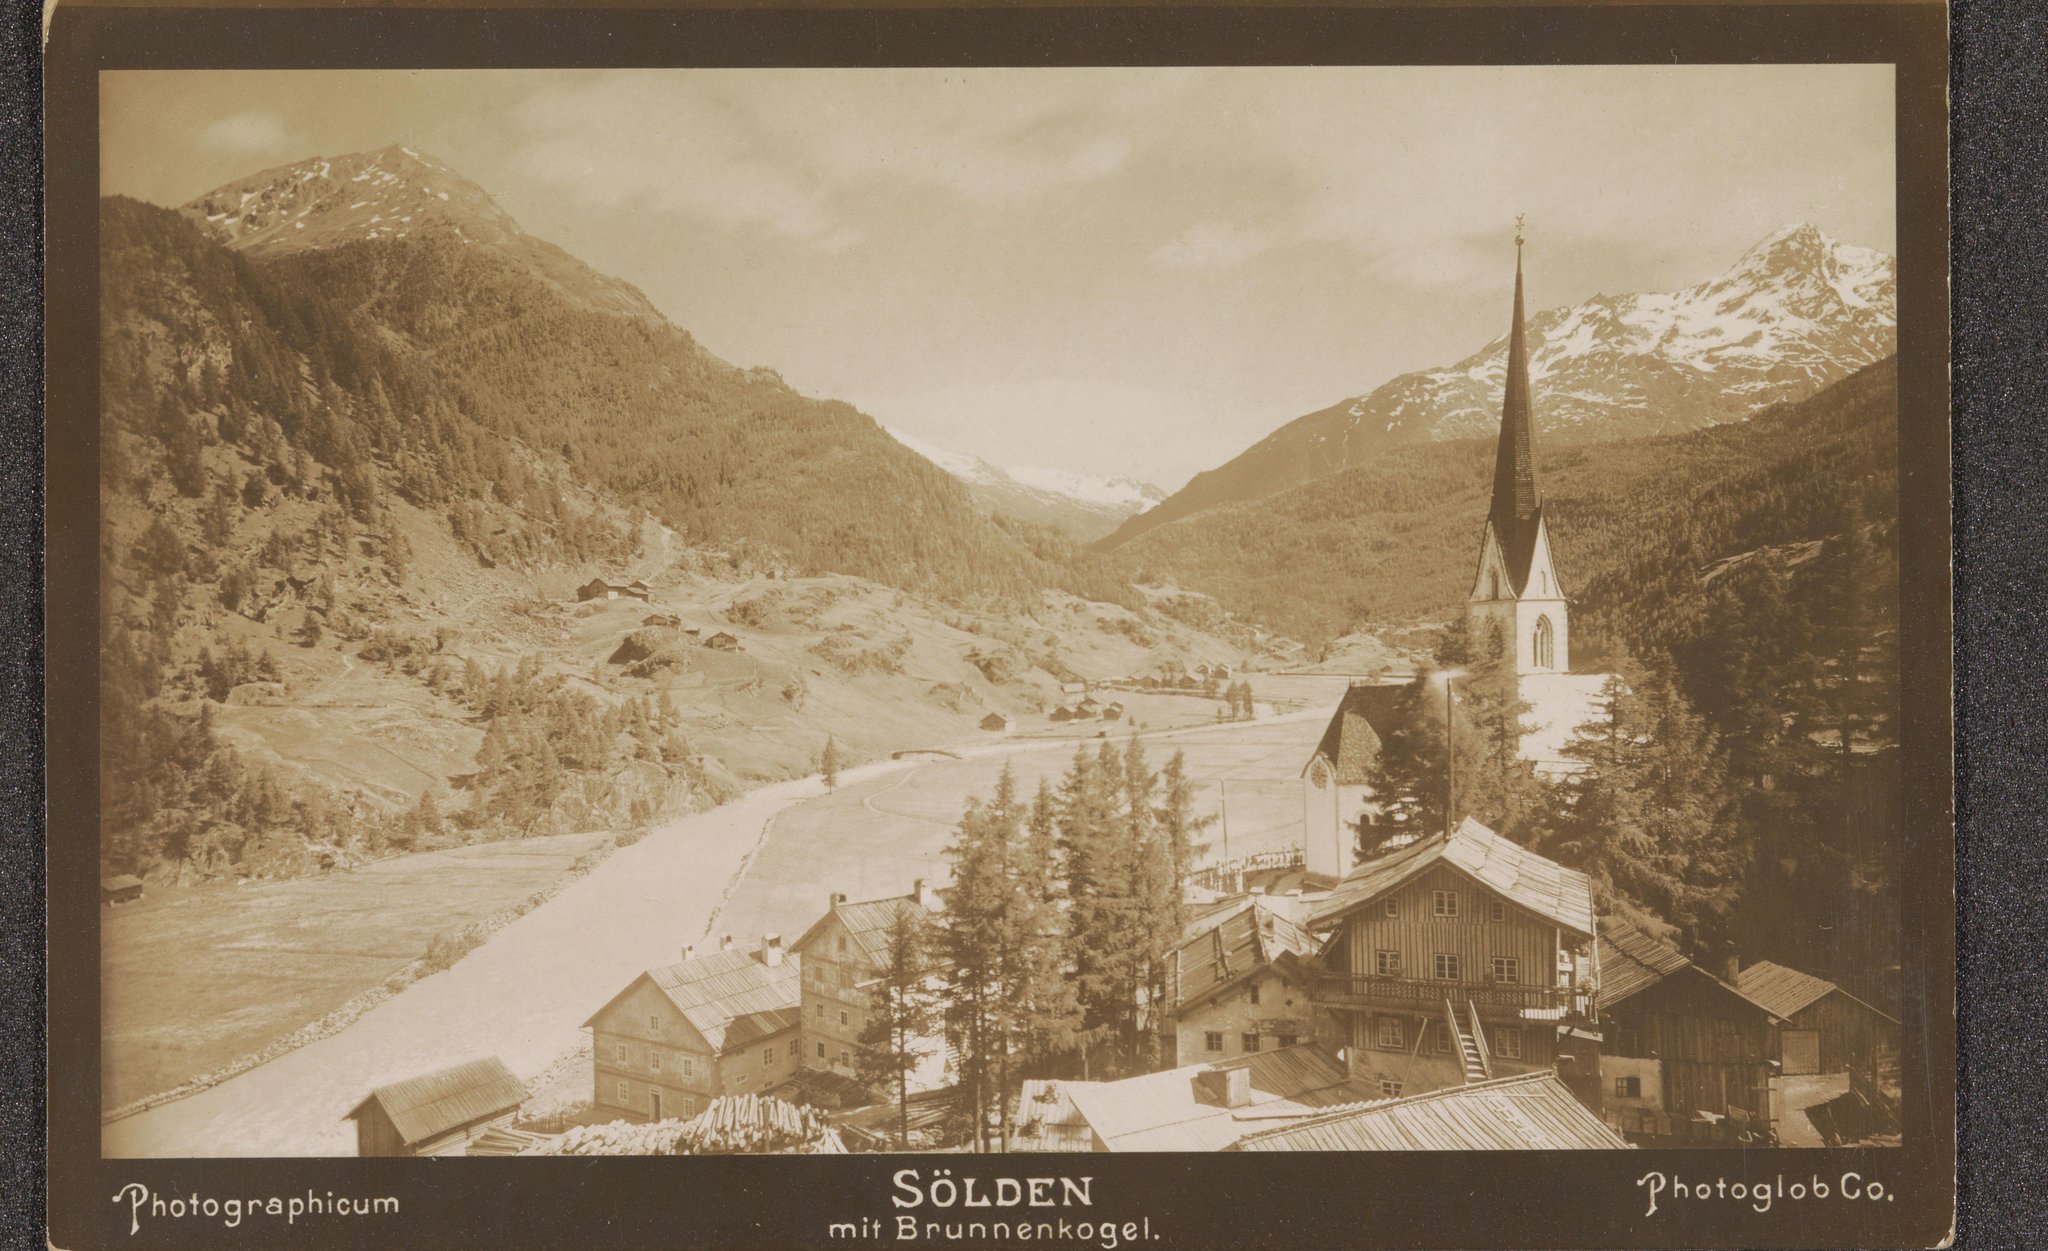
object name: photograph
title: Sölden mit Brunnenkogel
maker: Anonymous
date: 1870-1898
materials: photographic support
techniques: gelatin silver print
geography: sölden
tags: prospect of village, silhouette of village, travelling; tourism, parts of church exterior and annexes: tower, mountains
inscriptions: name: ‘Gebroeders Dobbelmann, Zeepfabrikanten, Nijmegen.’, inscription: ‘Photographicum’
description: Foto hoort bij een serie van 28 losse prentbriefkaarten van Engeland, Noorwegen, Italië, Duitsland en Tirol (foto's RP-F-F00945-1 t/m RP-F-F00945-28).